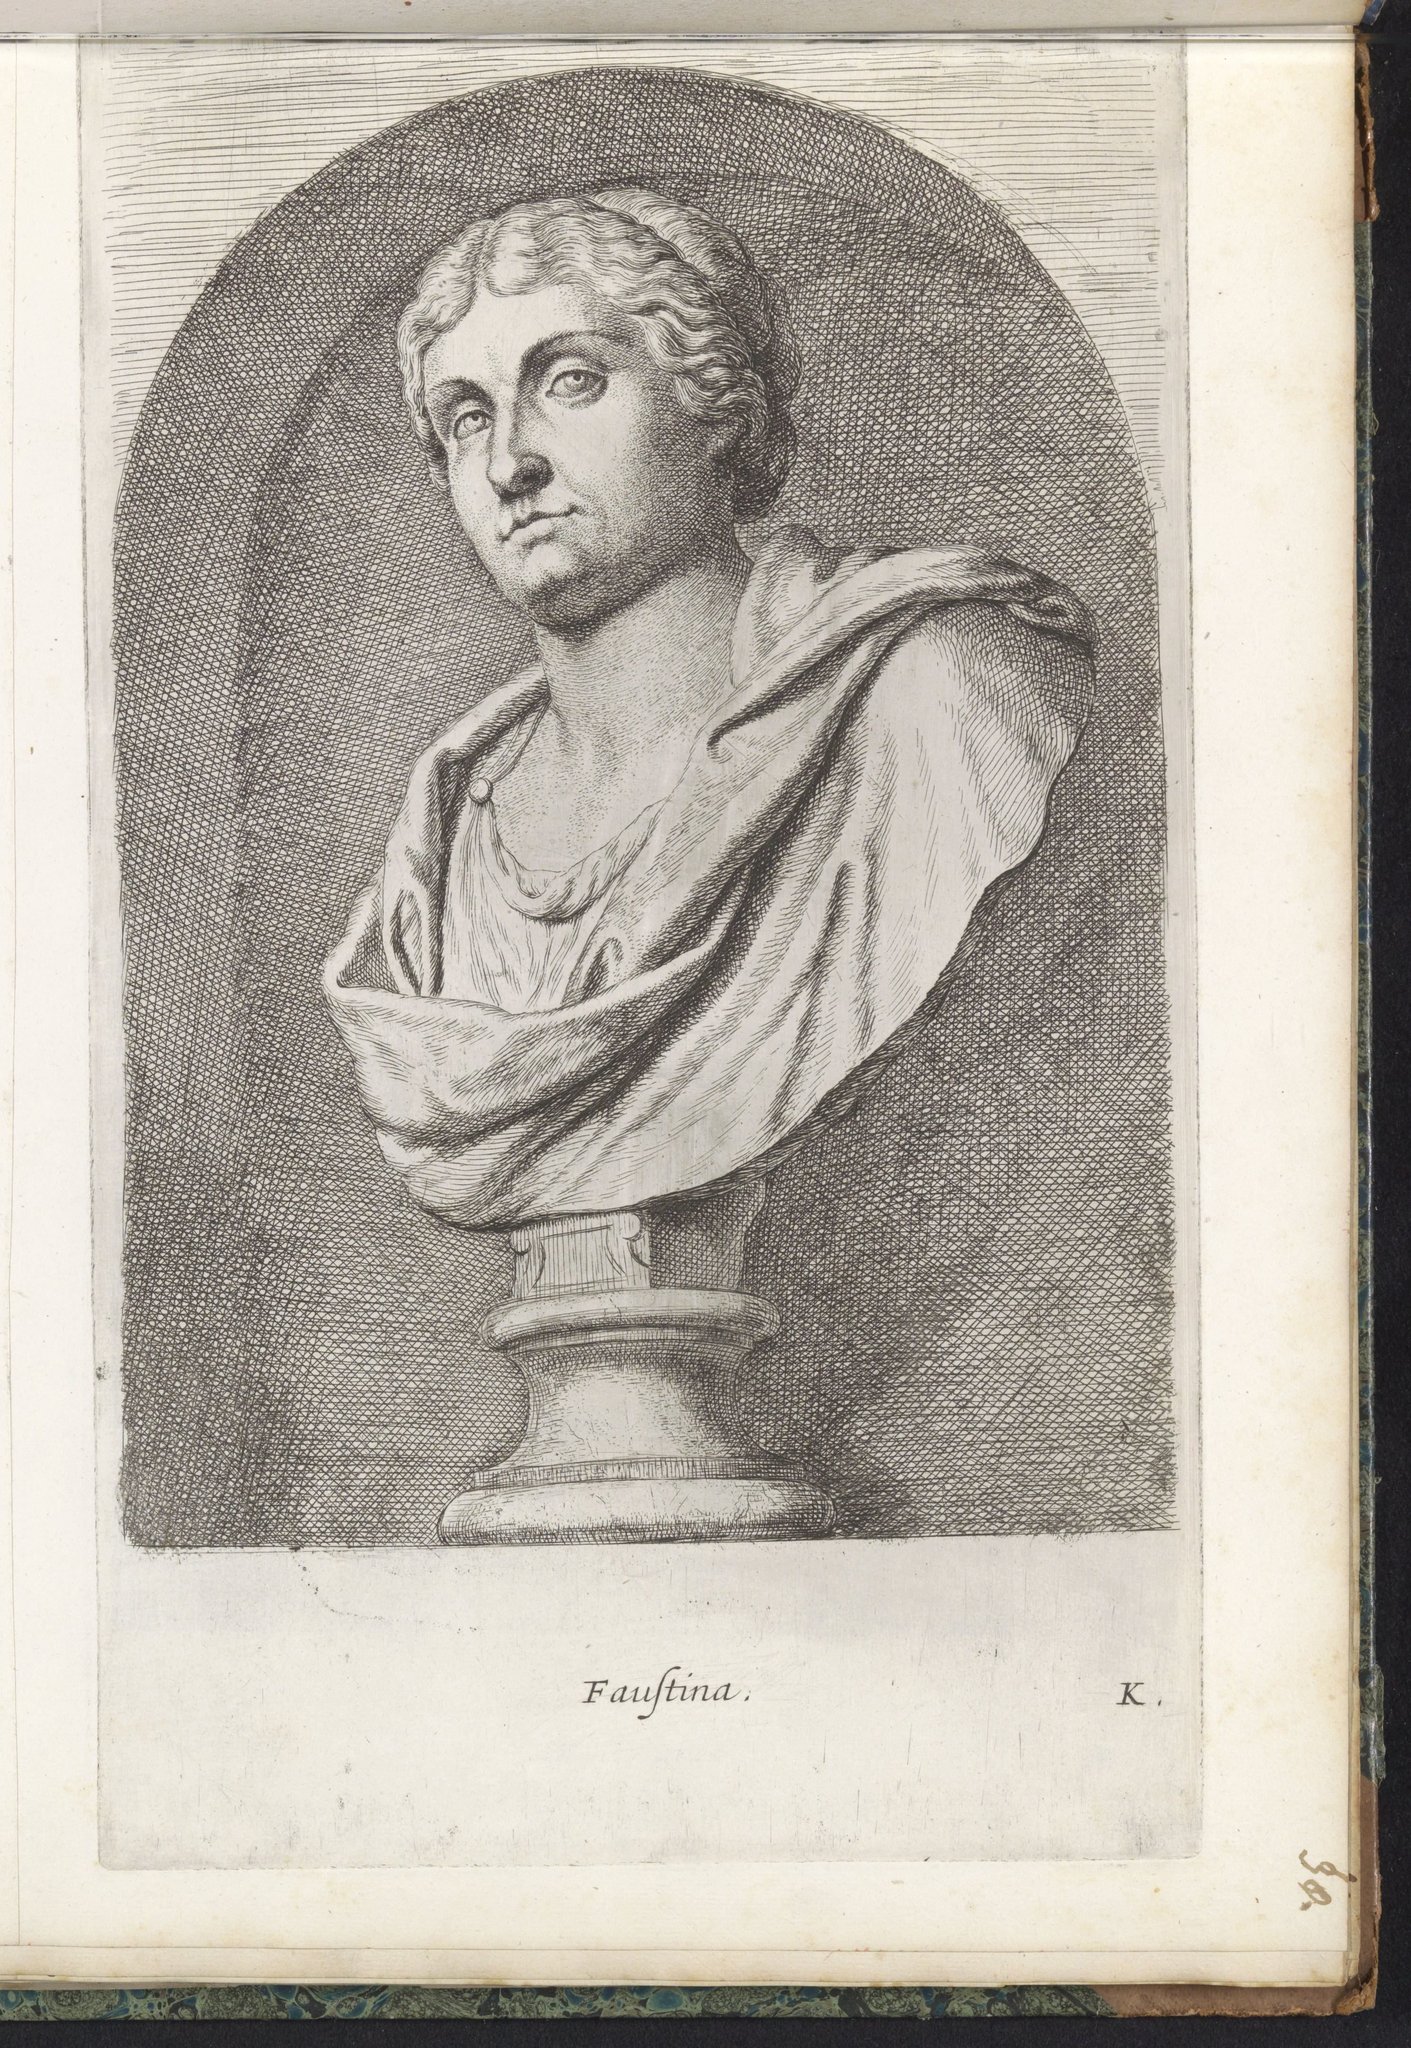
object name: print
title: Faustina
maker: hubert quellinus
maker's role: print maker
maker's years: 1619-1687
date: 1646-1670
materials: paper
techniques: engraving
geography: antwerp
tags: queen, empress, etc. (wife of a ruler), piece of sculpture, reproduction of a piece of sculpture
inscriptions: number: ‘38’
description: Klassieke buste van een vrouw van middelbare leeftijd, gekleed in tunica en stola. Rechtsonder: K. De prent maakt deel uit van een album met een serie prenten naar de sculpturen in de verzameling van Gerard Reynst.